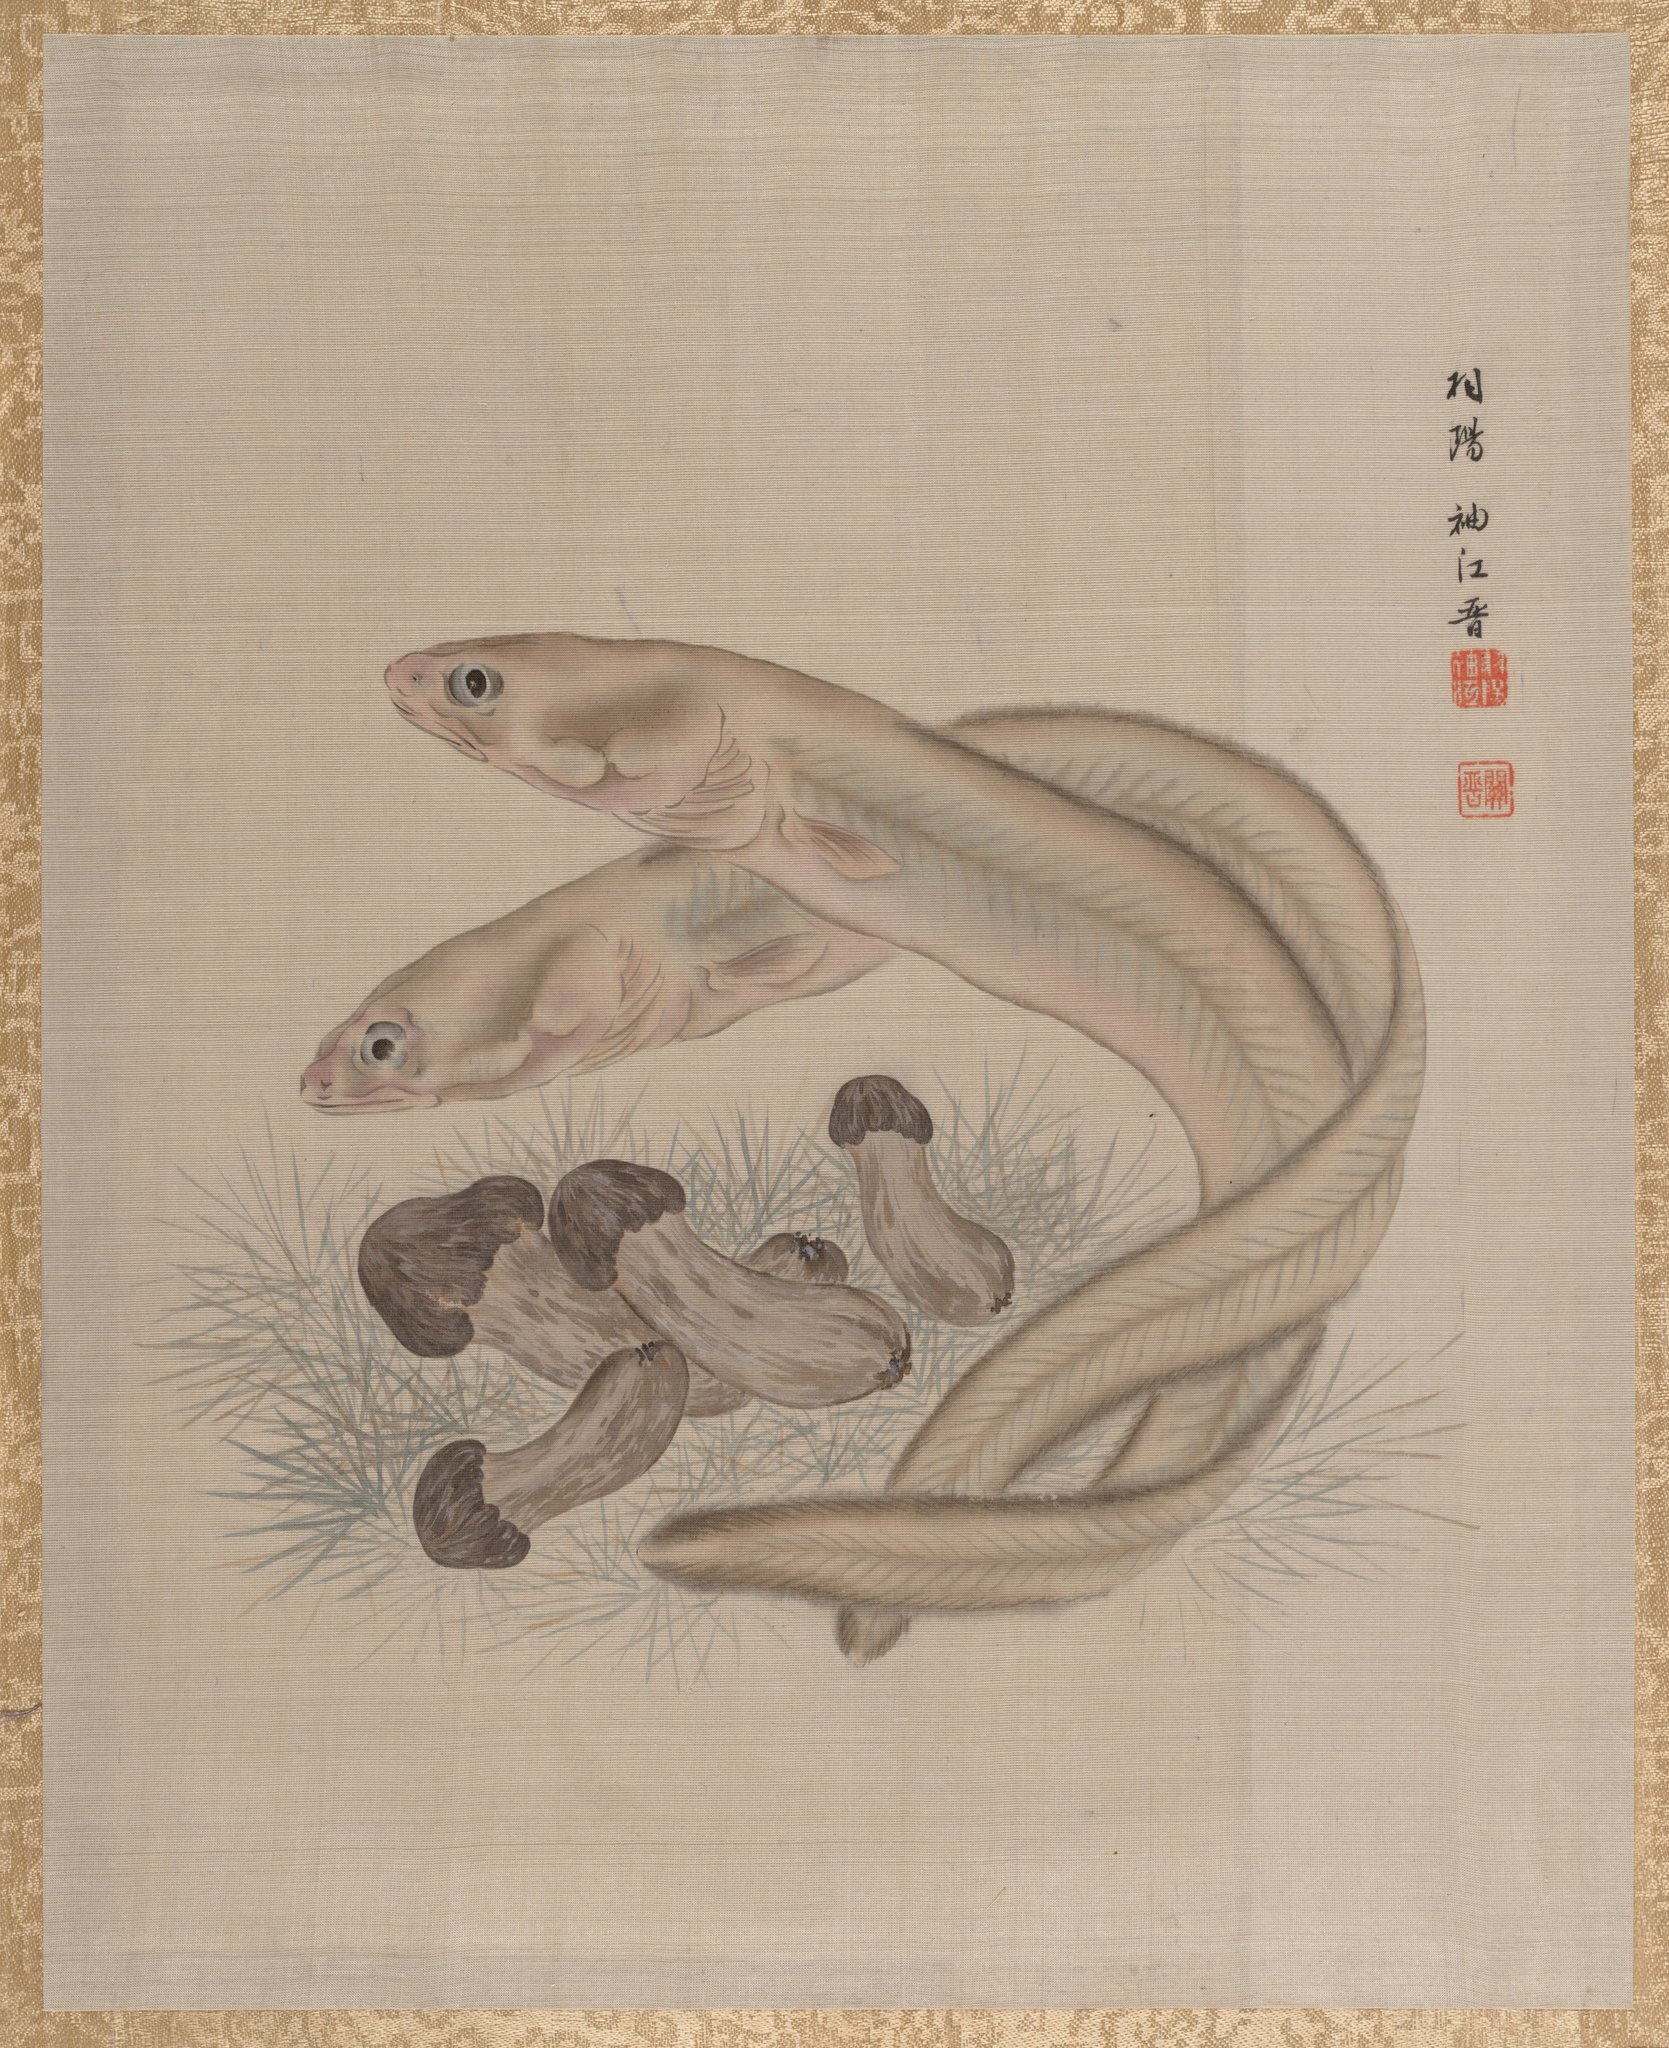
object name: album leaf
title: Eels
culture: japanese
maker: seki shūkō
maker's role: artist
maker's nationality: japanese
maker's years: 1858-1915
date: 1890-1892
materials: silk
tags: fish